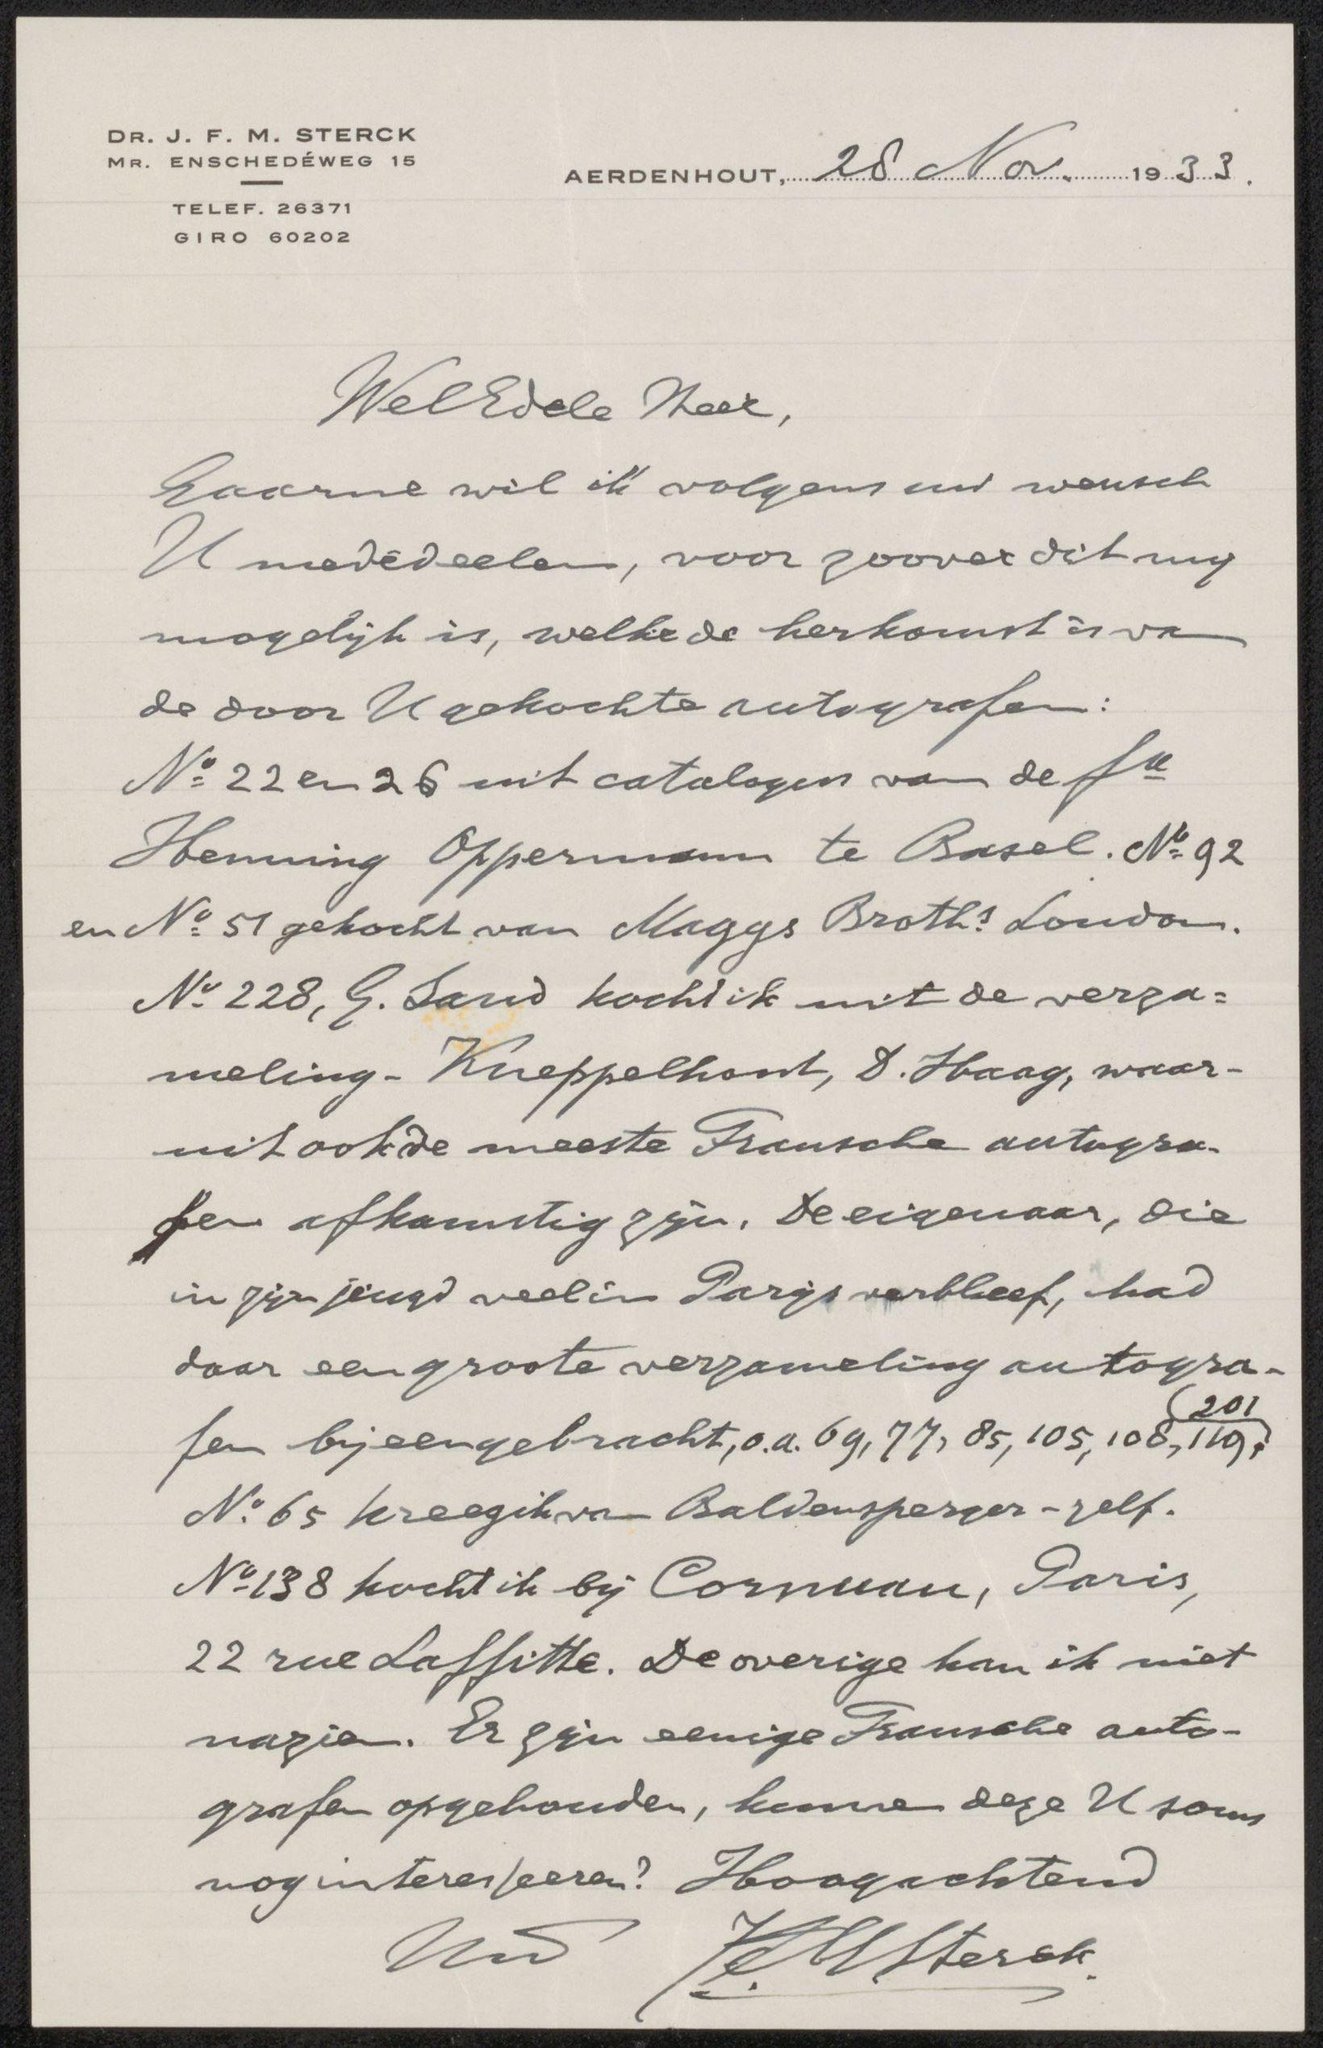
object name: letter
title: Brief aan de heer J.J.W.B. van Dijck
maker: johannes franciscus maria sterck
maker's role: letterkundige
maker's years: 1859-1941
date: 1933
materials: ink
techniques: pen, printing, writing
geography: aerdenhout